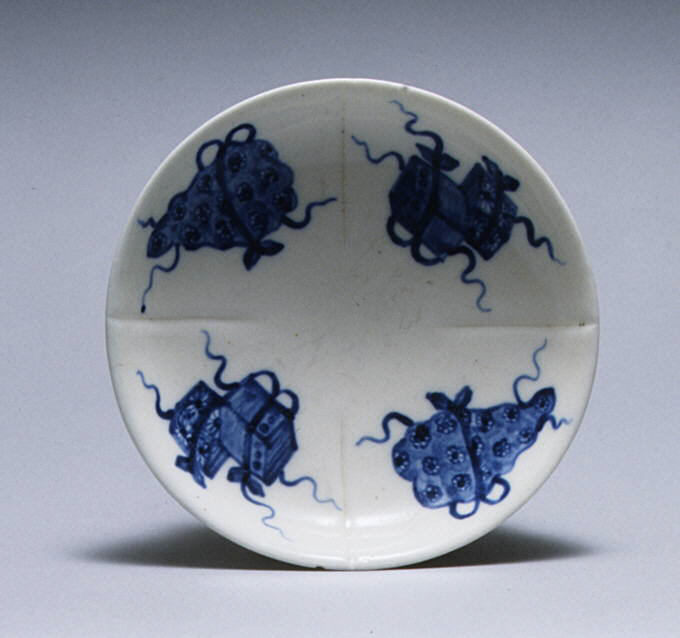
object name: saucer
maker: saint-cloud factory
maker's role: factory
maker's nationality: french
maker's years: 1693-1766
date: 1715-1725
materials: soft paste porcelain